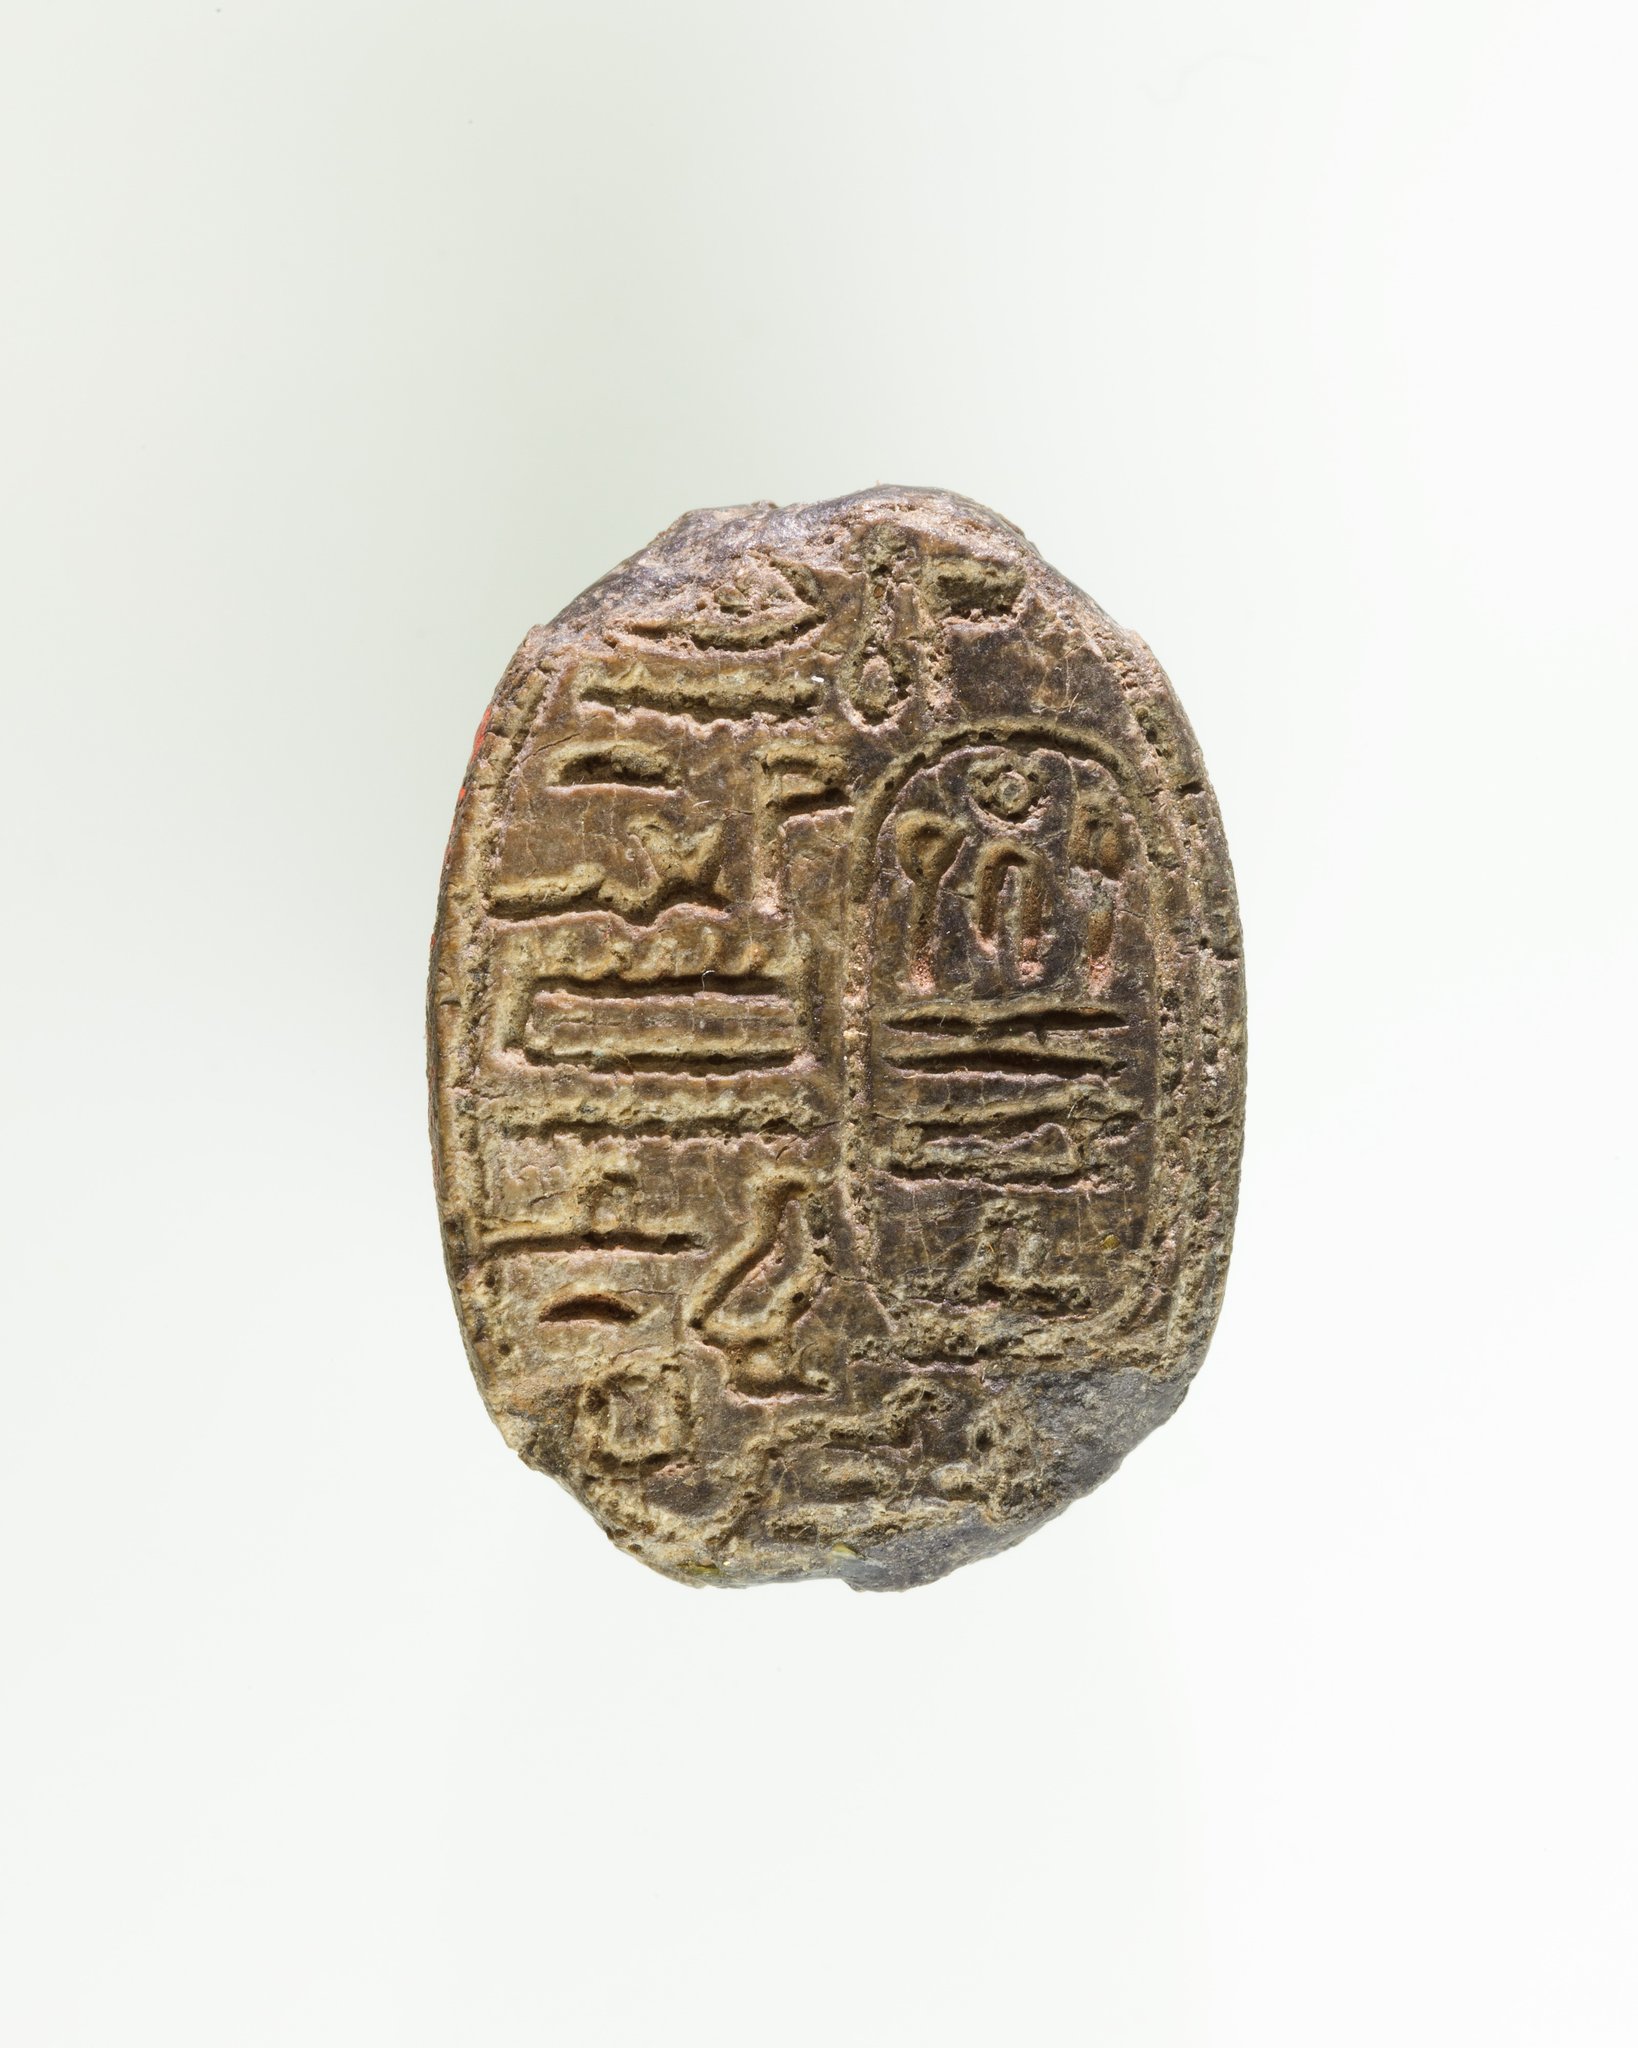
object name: scarab, sebekhotep iii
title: Scarab of Sebekhotep III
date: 1748-1741 BCE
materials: glaze, stone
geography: egypt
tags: hieroglyphs,scarabs